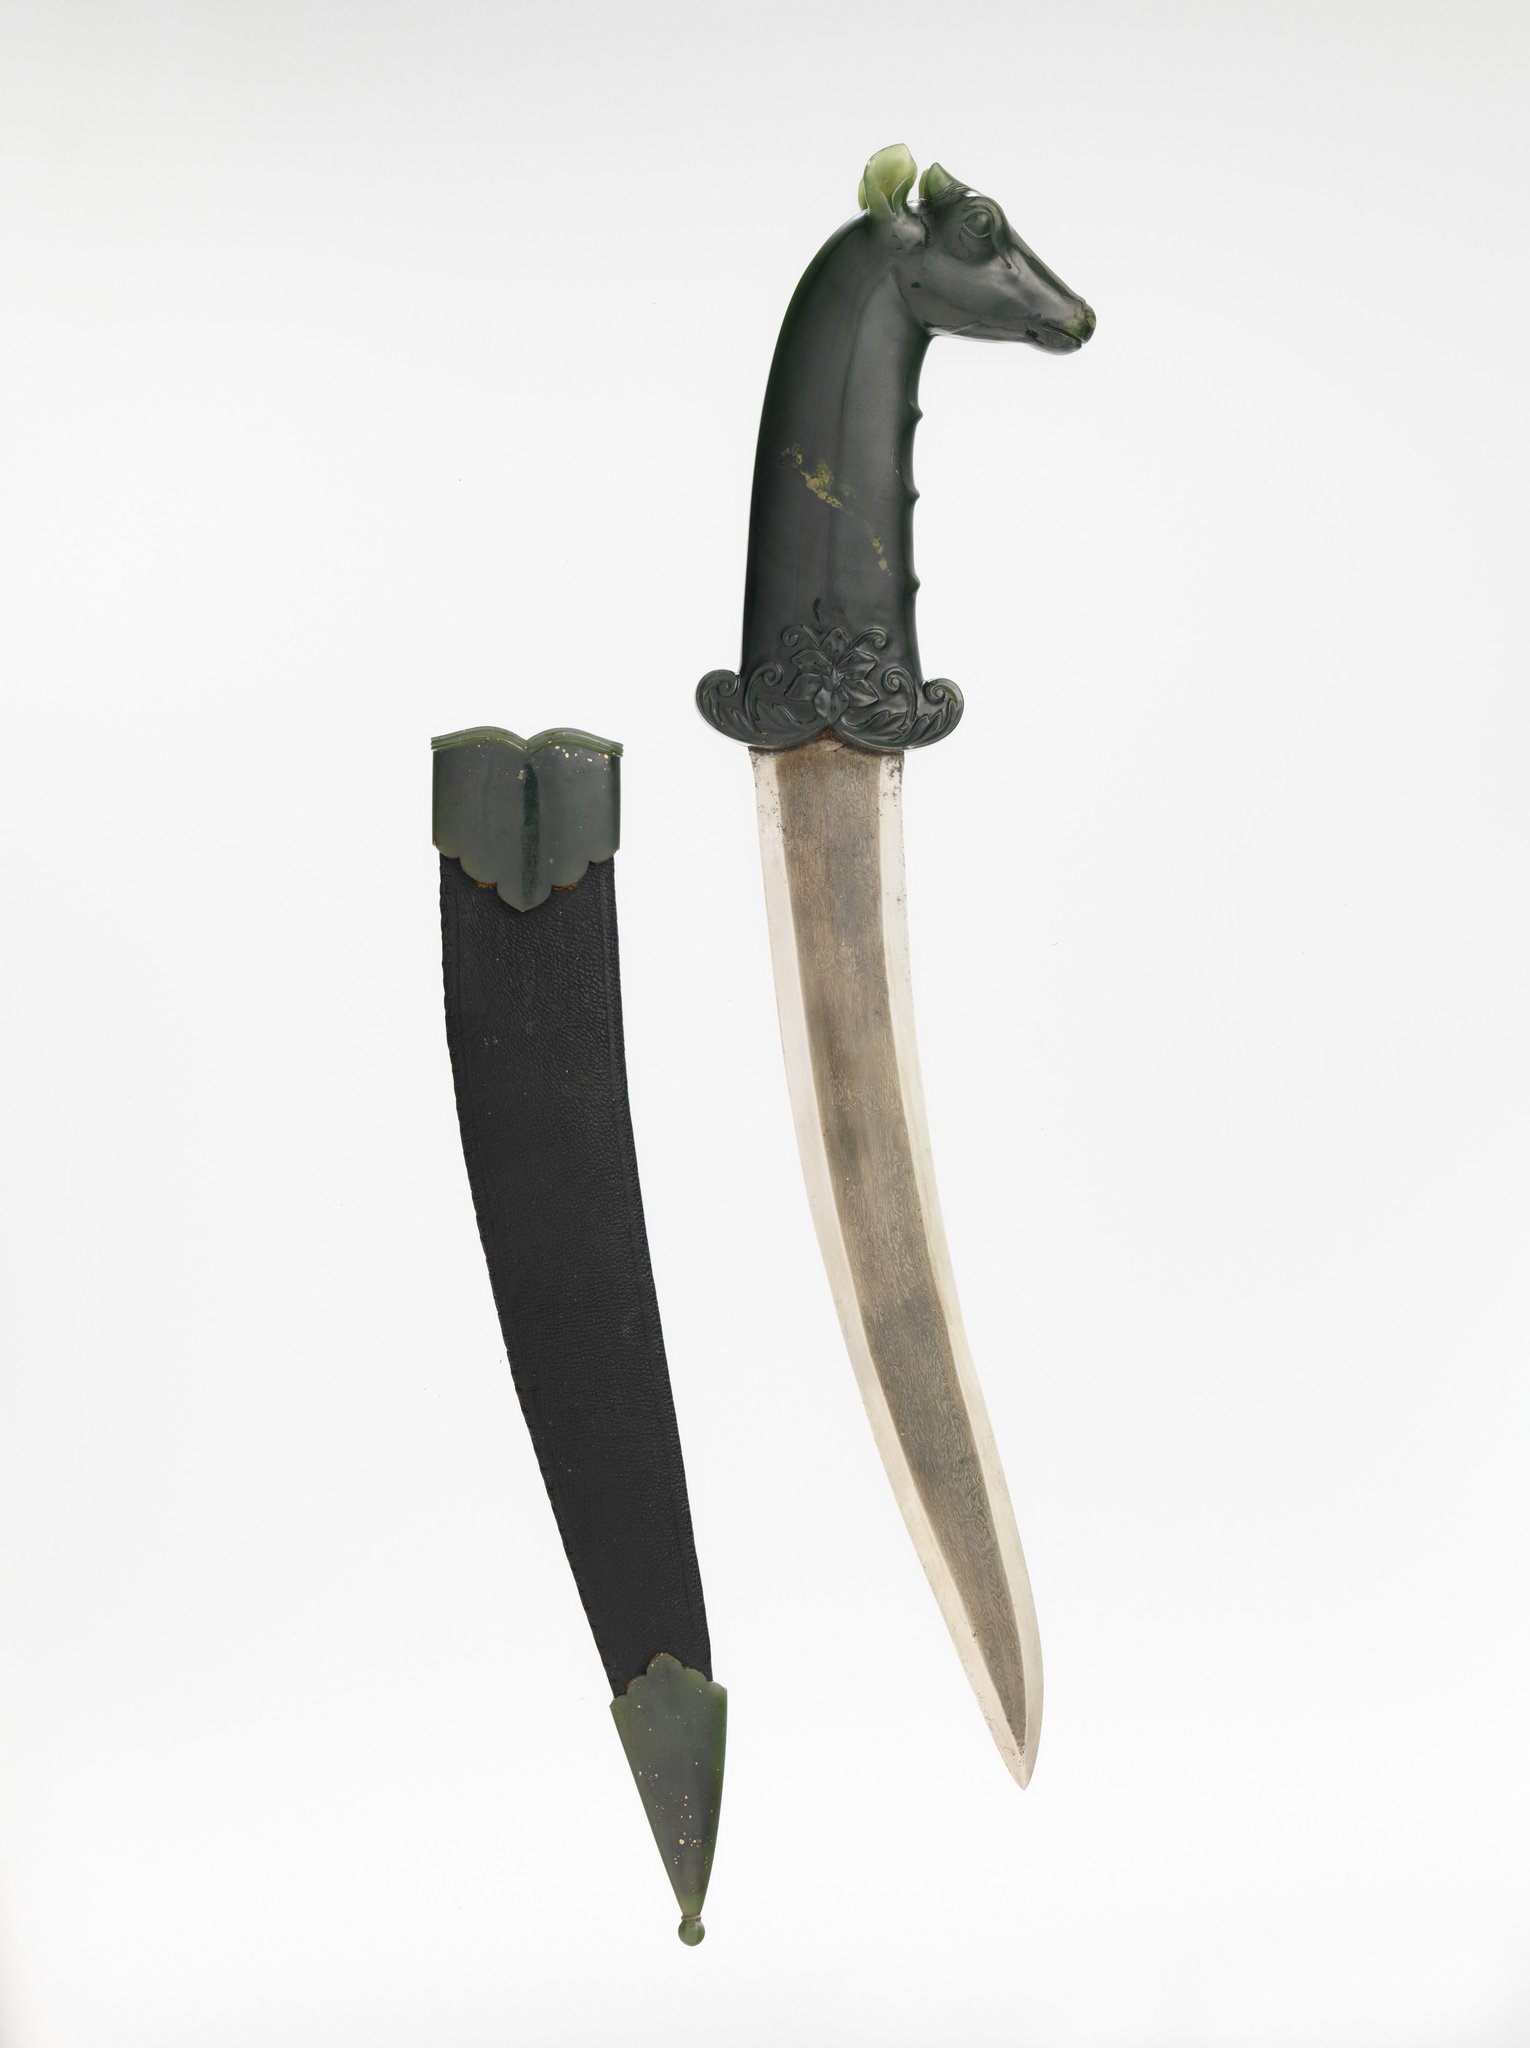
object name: dagger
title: Dagger with Hilt in the Form of a Blue Bull (Nilgai)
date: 1640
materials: jade, steel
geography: india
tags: bulls